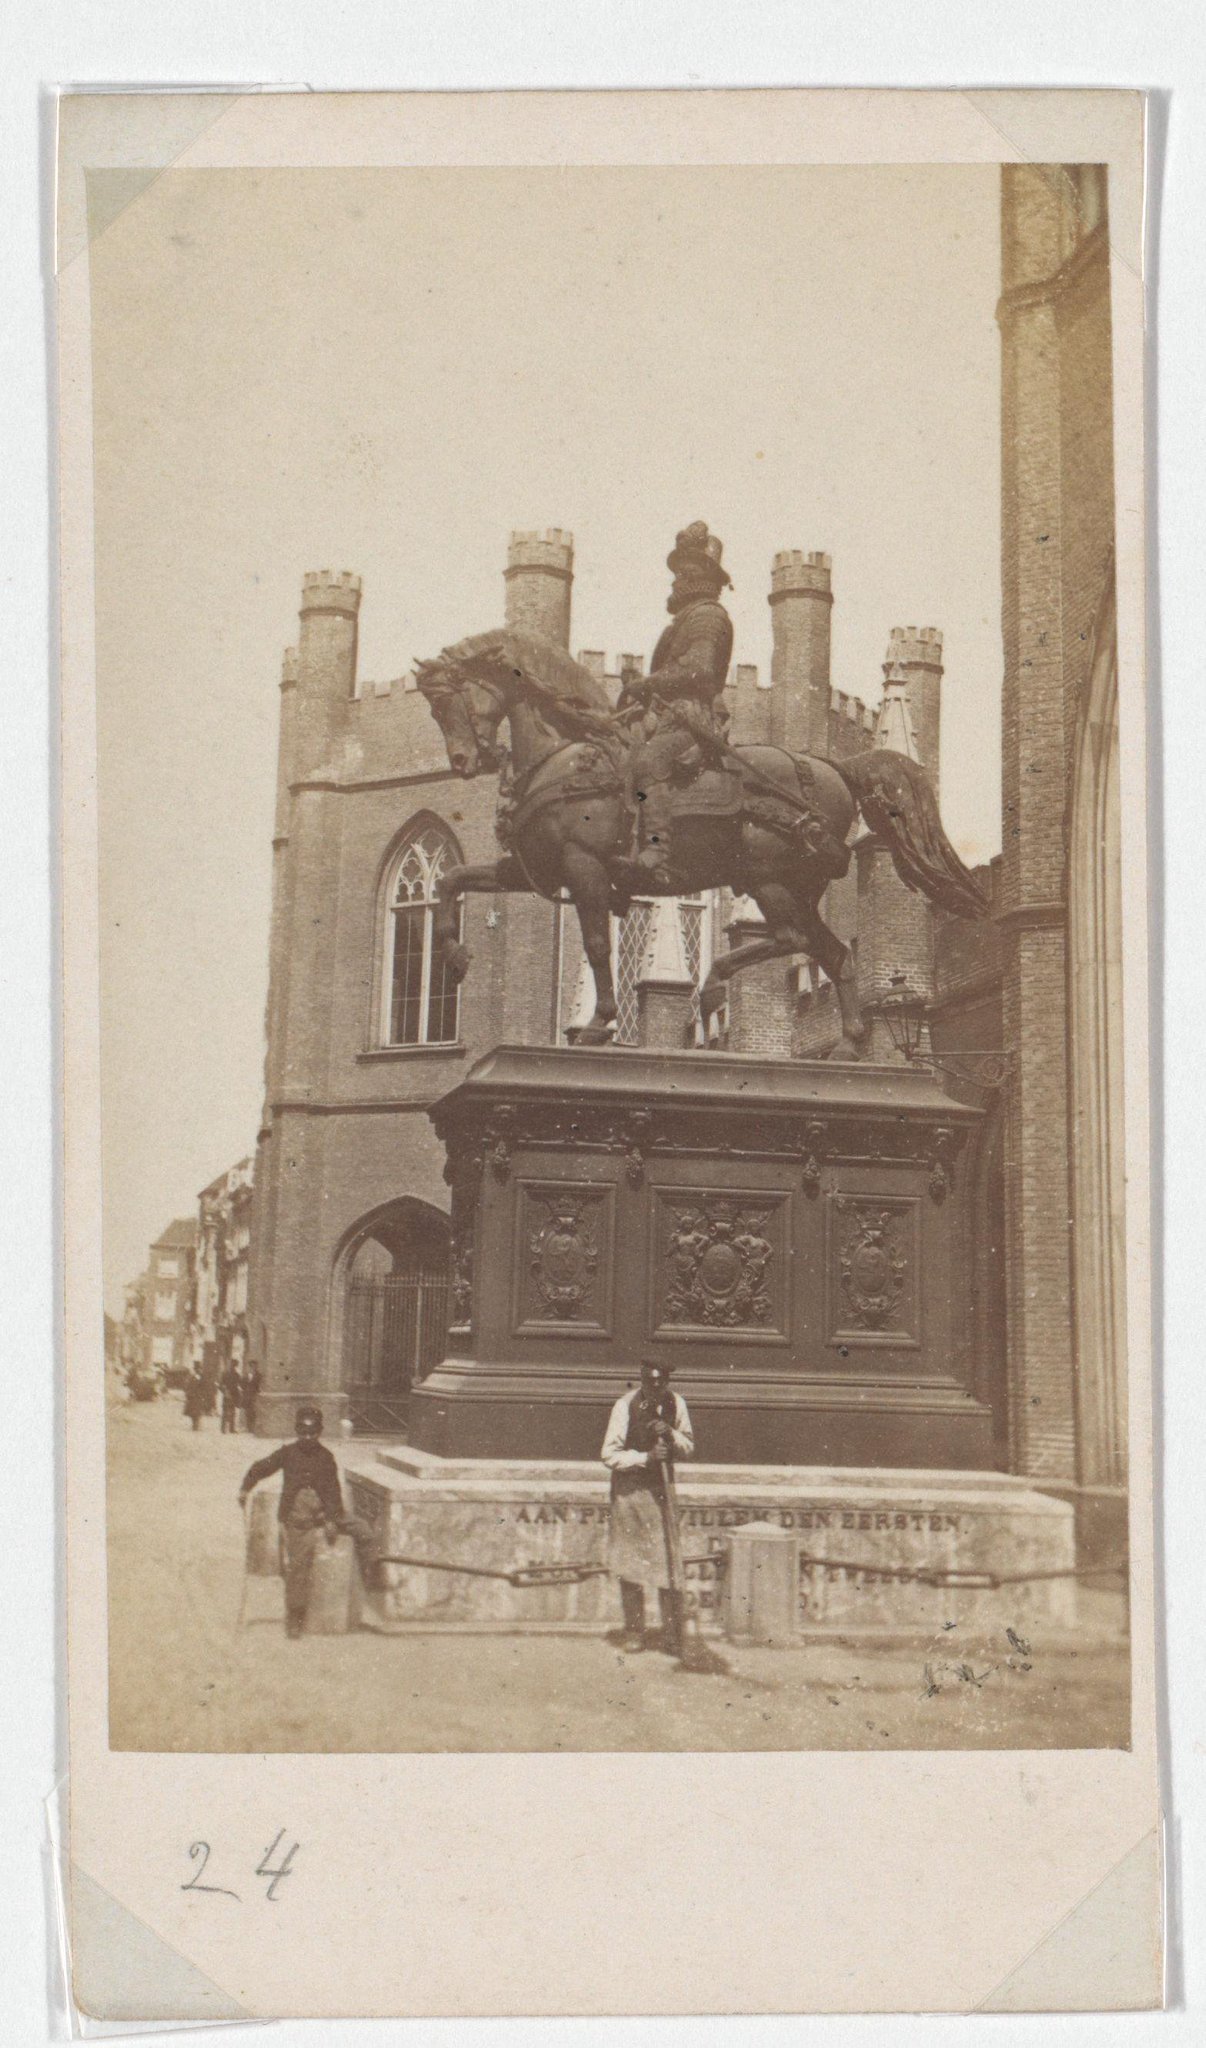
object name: photograph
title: Ruiterstandbeeld van Willem van Oranje in Den Haag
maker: Anonymous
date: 1860-1880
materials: cardboard, paper, photographic support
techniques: albumen print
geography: the hague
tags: delft, william i (prince of orange), equestrian statue, the hague